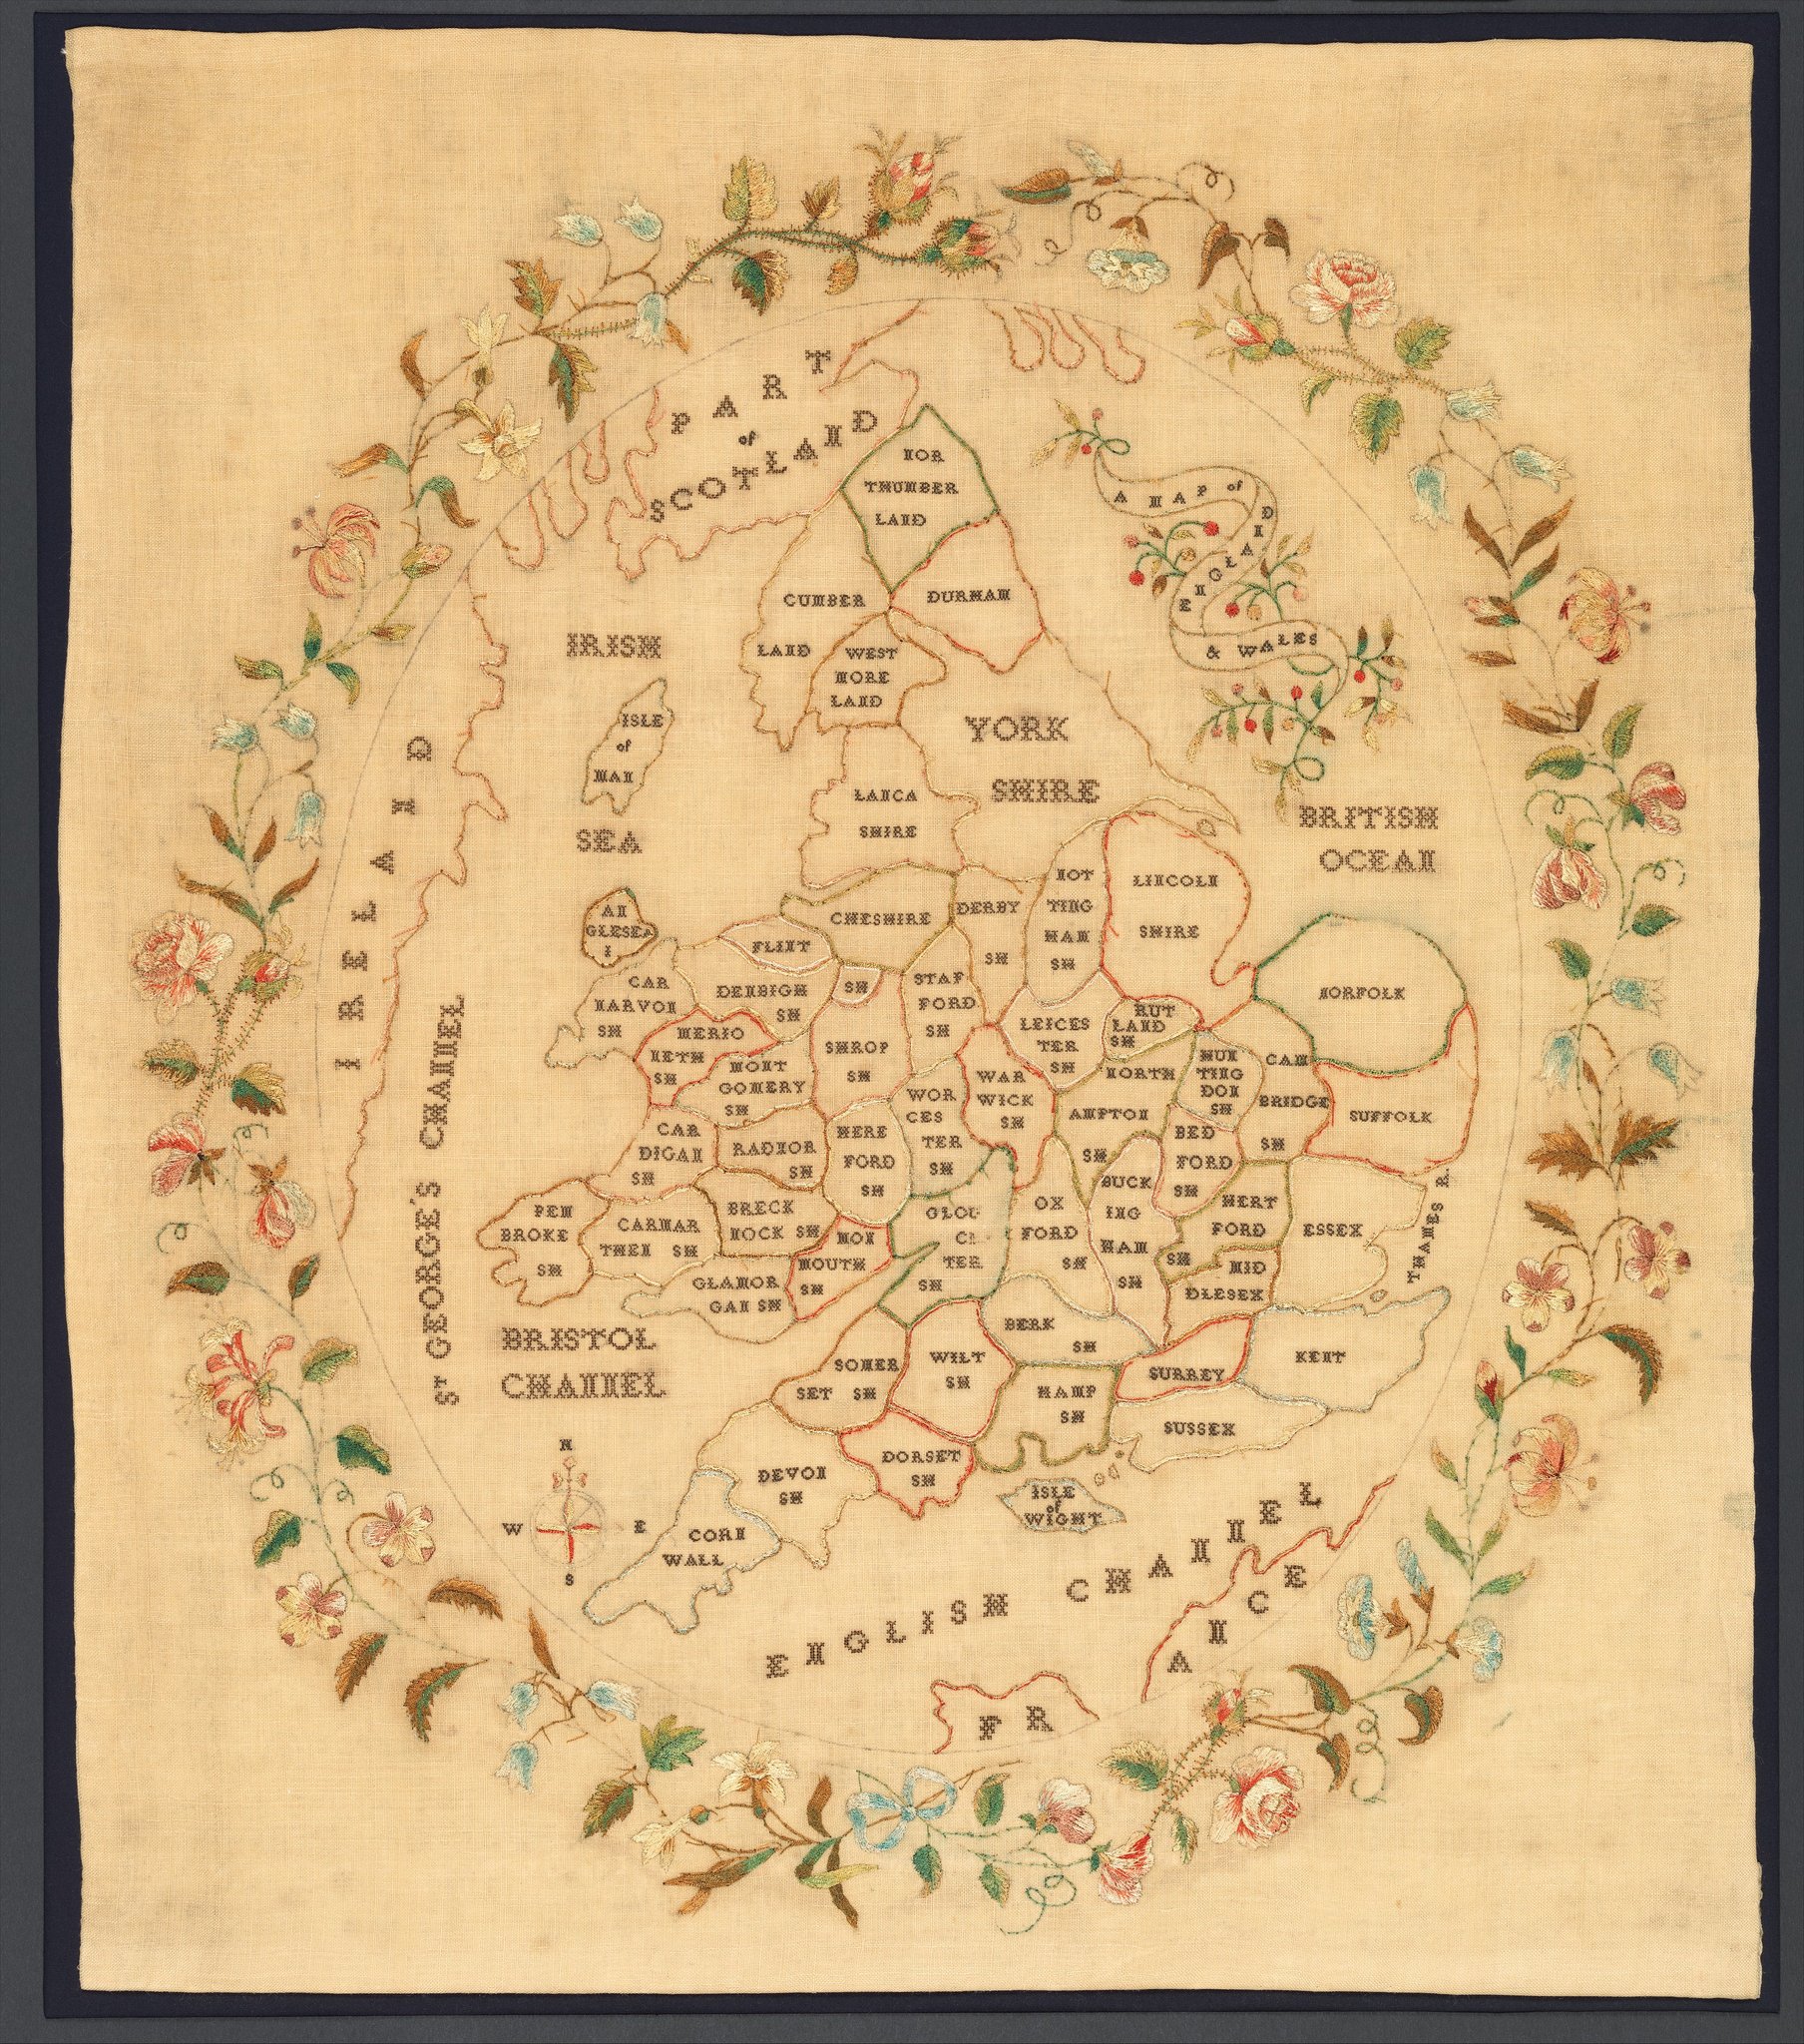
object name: sampler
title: Embroidered map sampler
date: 1835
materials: silk, wool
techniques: embroidery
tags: flowers,maps